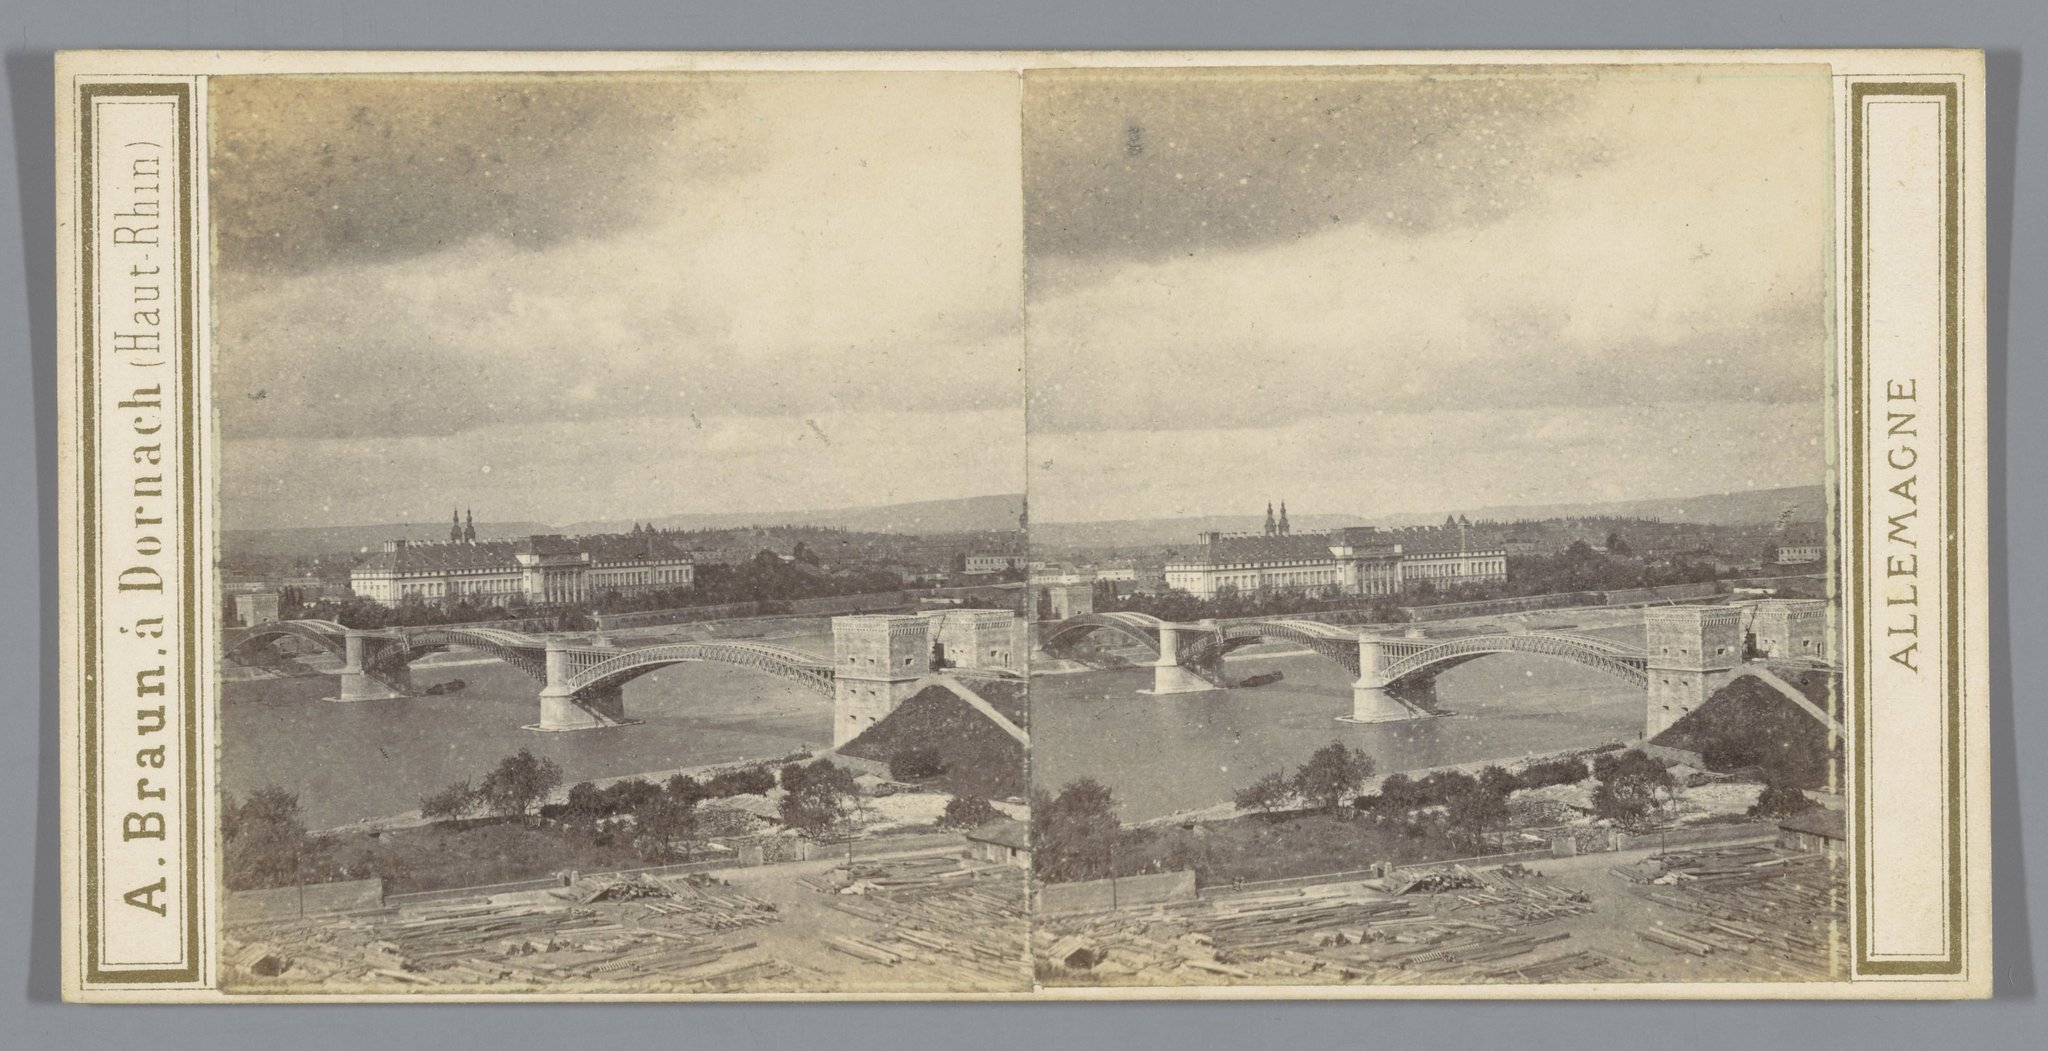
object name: stereograph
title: Allemagne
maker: Anonymous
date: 1864-1866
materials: cardboard, paper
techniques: albumen print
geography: koblenz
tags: bridge in city across river, canal, etc.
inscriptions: number: ‘No 4917.’